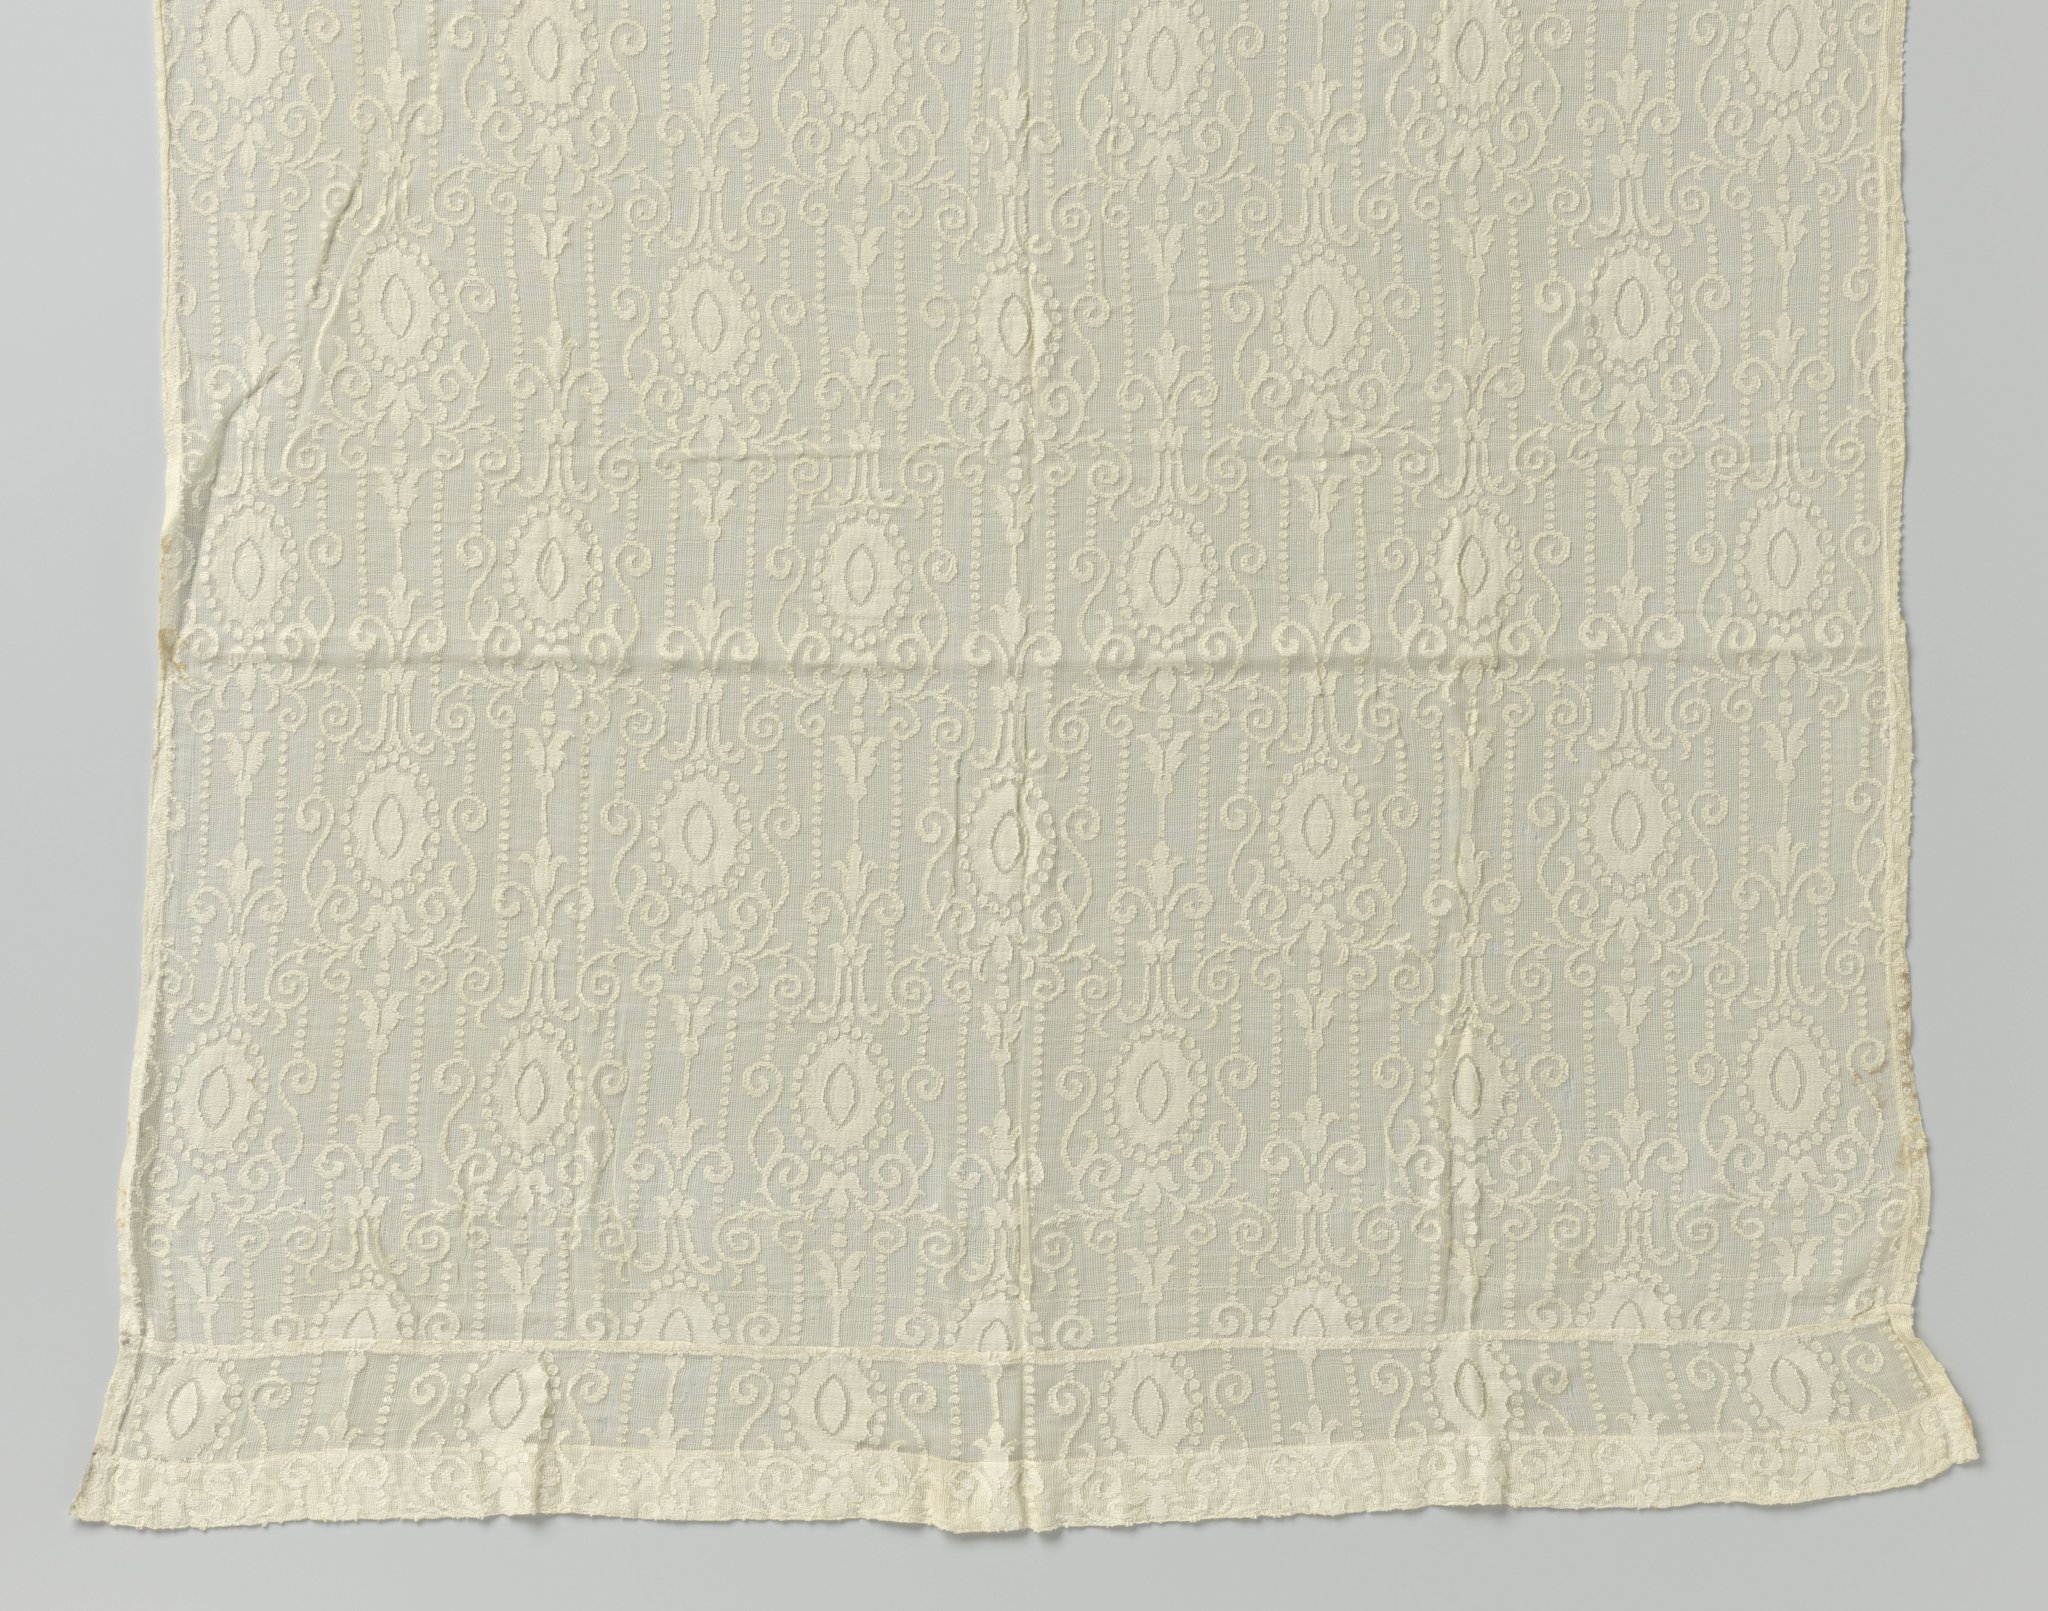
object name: sheer curtain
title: Fragment van een vitrage in neo Lodewijk-XVI stijl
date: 1895-1905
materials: cotton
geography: netherlands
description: Fragment van vitrage in neo Lodewijk-XVIe stijl.